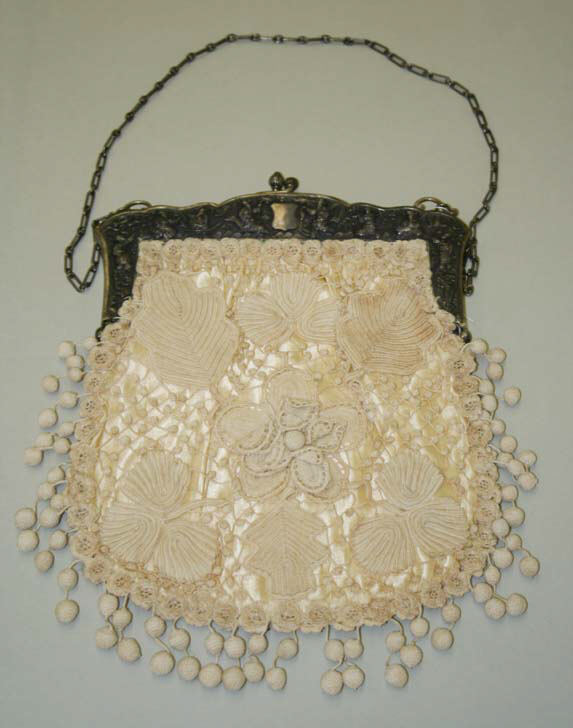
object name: bag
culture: french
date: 1867-1900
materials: metal